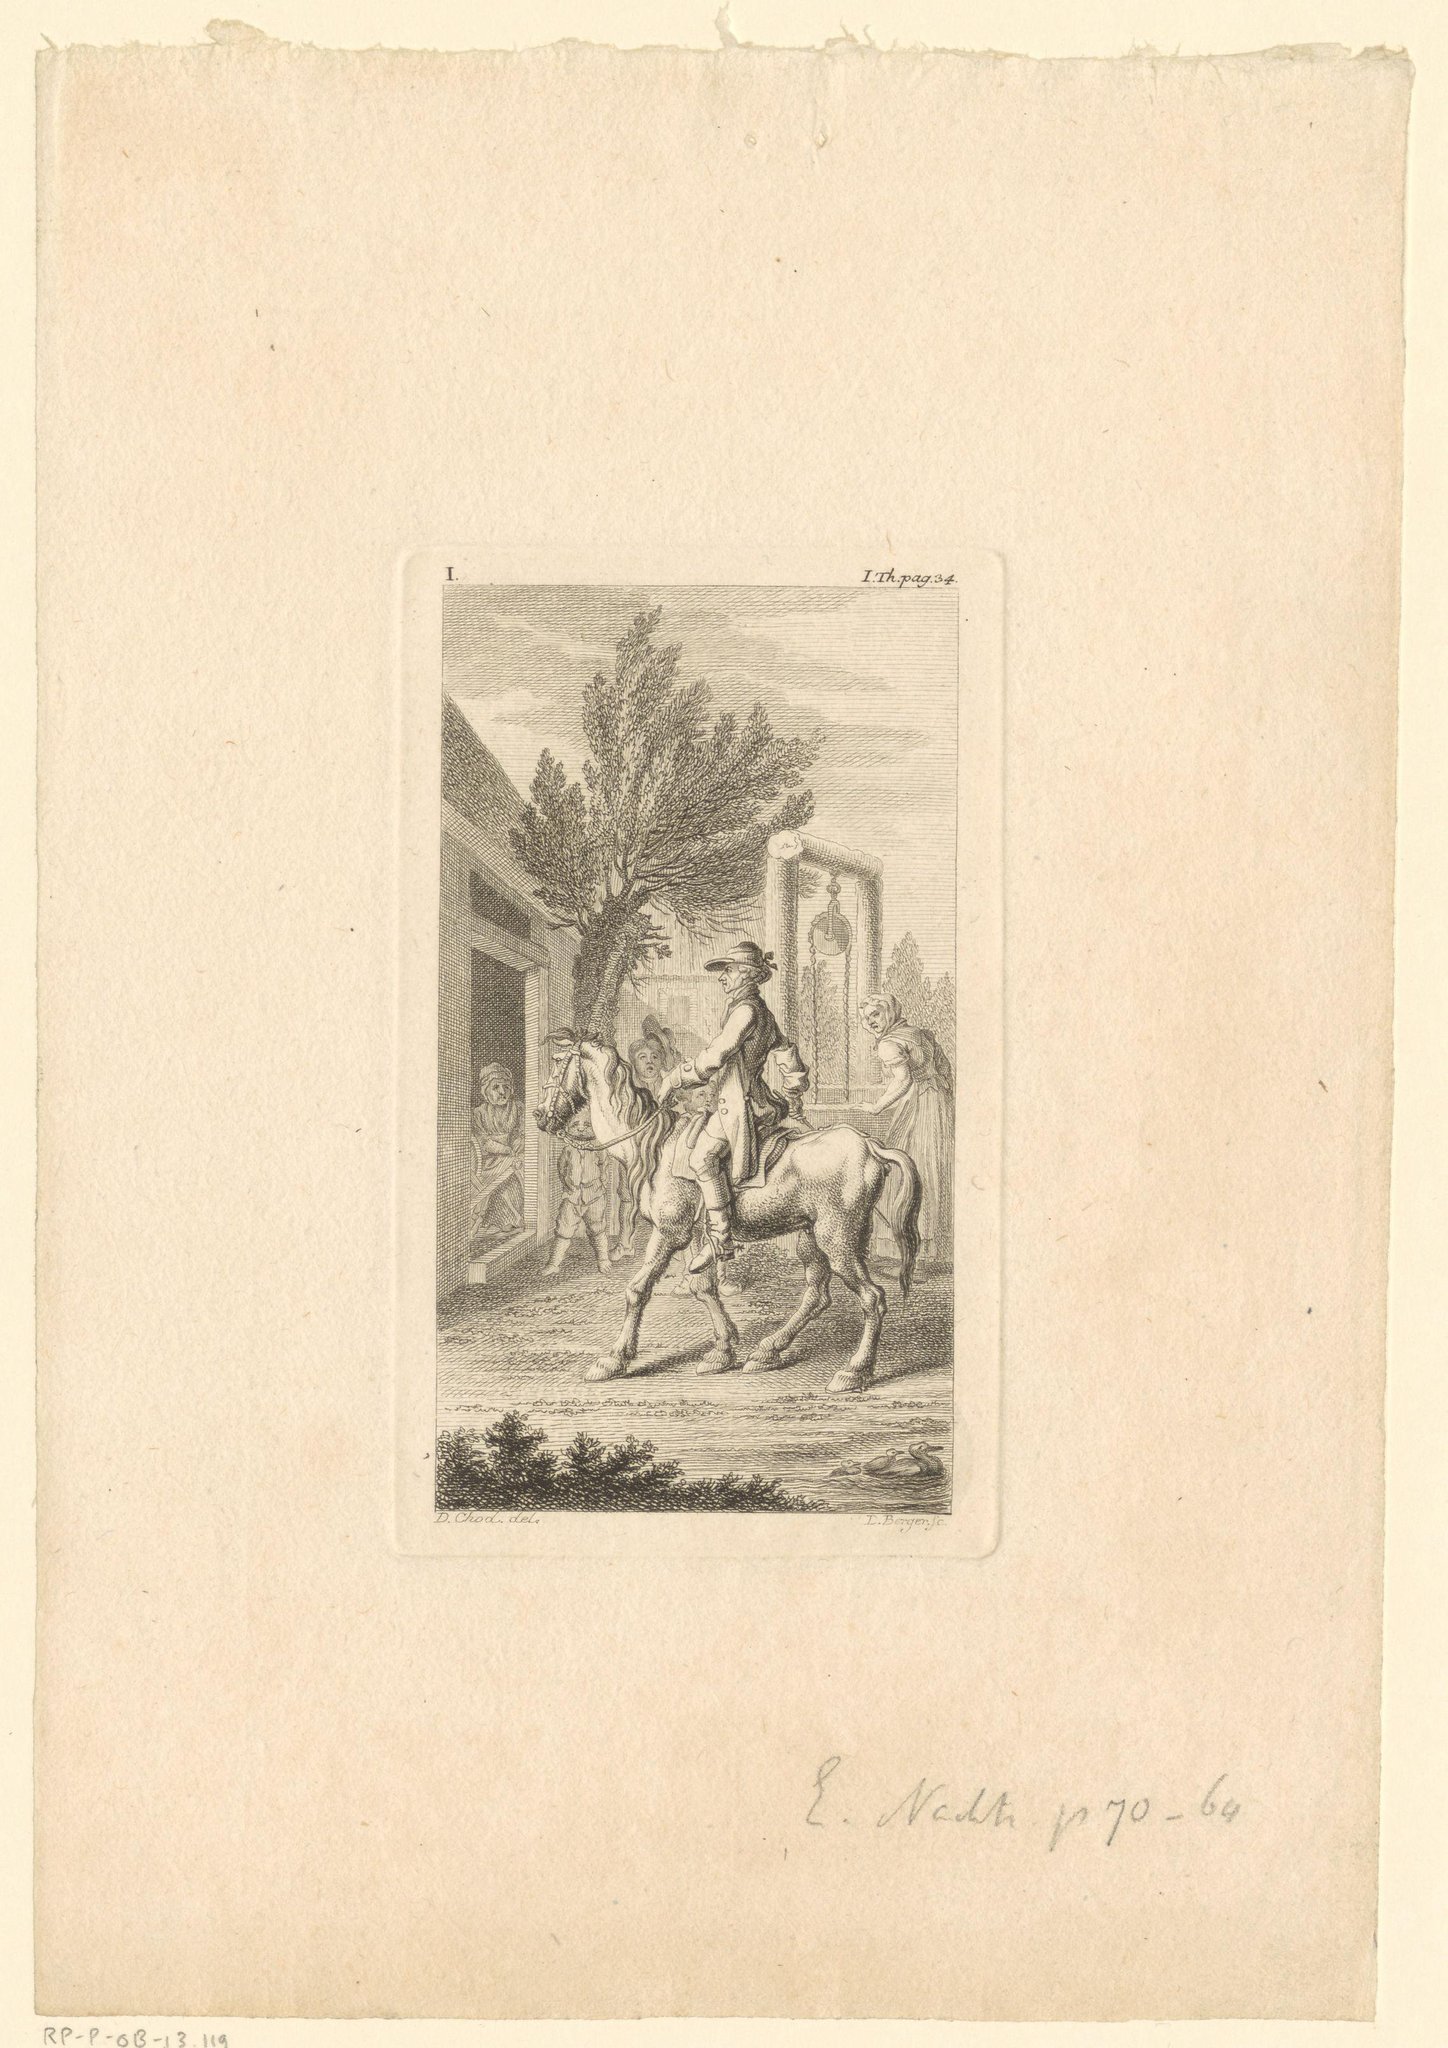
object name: print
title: XII Kupfer zu den Leben und Meynungen Tristram Shandy's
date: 1778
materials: paper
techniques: etching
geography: berlin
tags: london, clergyman, riding a horse, ass, or mule; rider, horseman, well, literary characters and objects, functionaries and dignitaries (with name) ~ episcopal protestant churches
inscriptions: collector's mark: Lugt 240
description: Eerste prent uit de serie 'XII Kupfer zu den Leben und Meynungen Tristram Shandy's', bestaand uit een titelpagina en 12 prenten, gedrukt op kosten van de Berlijnse boekhandelaar Christian Friedrich Himburg in 1778. De illustraties volgen een eerder verschenen tekstuitgave: [Stern, Laurence]. Tristram Schandis Leben und Meynungen [uit het Duits vertaald door] Johann Joachim Christoph Bode. 9 dln. Hamburg: Carl Ernst Bohn te Hamburg, 1776.